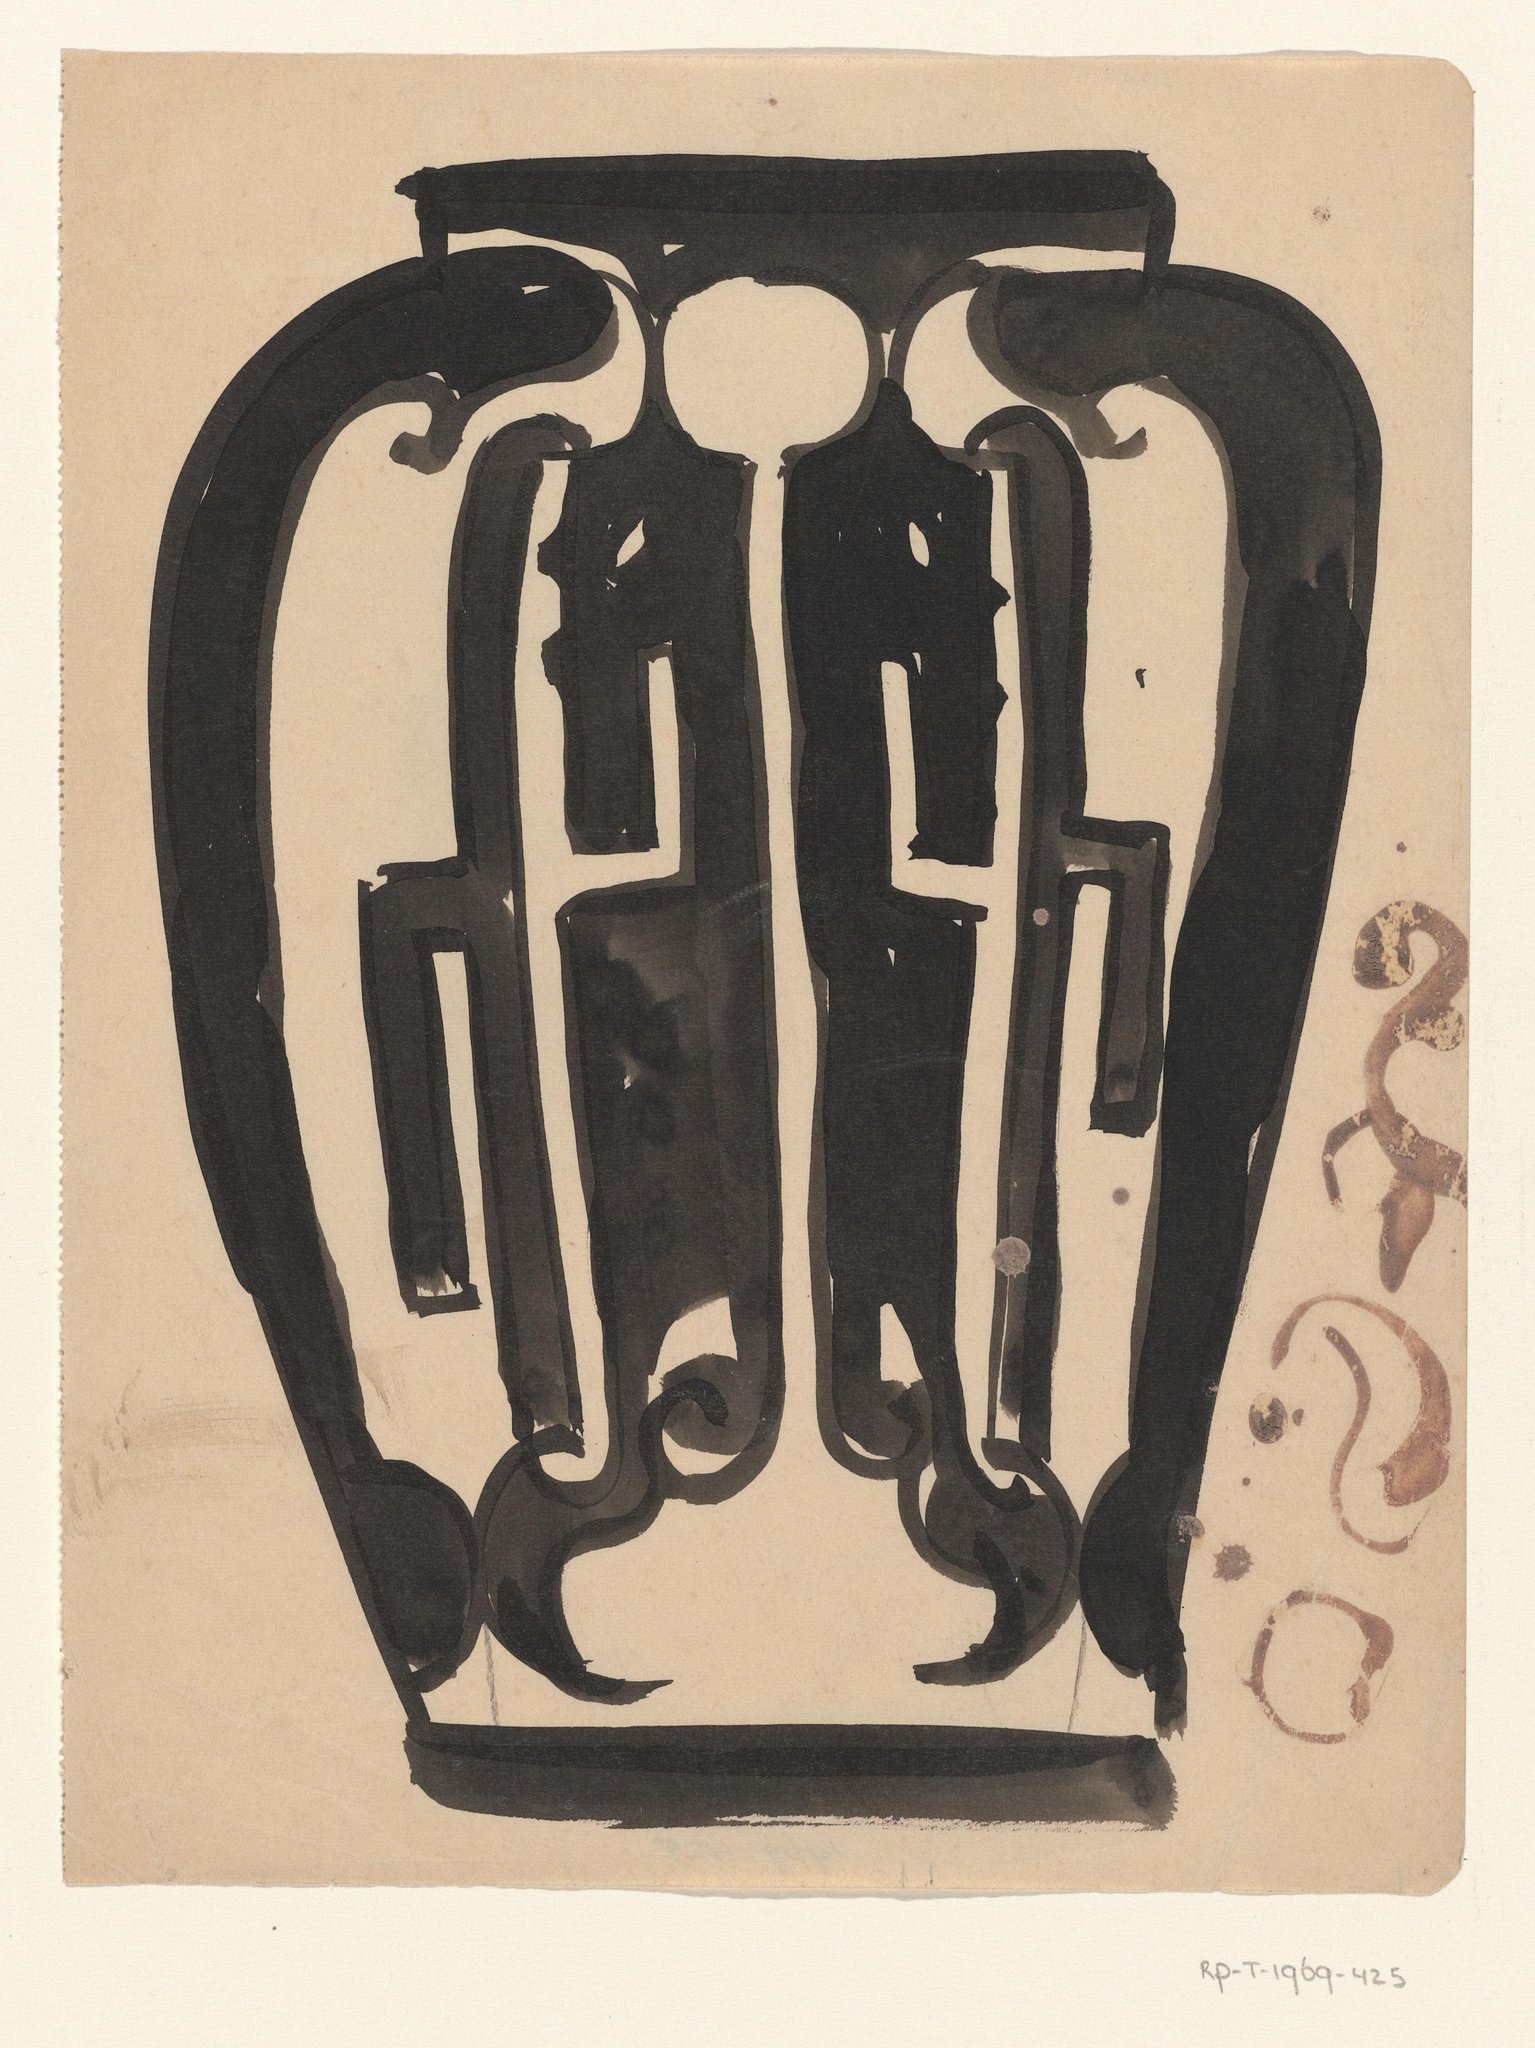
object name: design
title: Ontwerp voor een vaas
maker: carel adolph lion cachet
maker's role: draughtsman, print maker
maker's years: 1864-1945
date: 1874-1945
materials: squared paper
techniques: brush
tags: work of applied art (+ ceramics ~ arts), container of ceramics: jar, jug, pot, vase